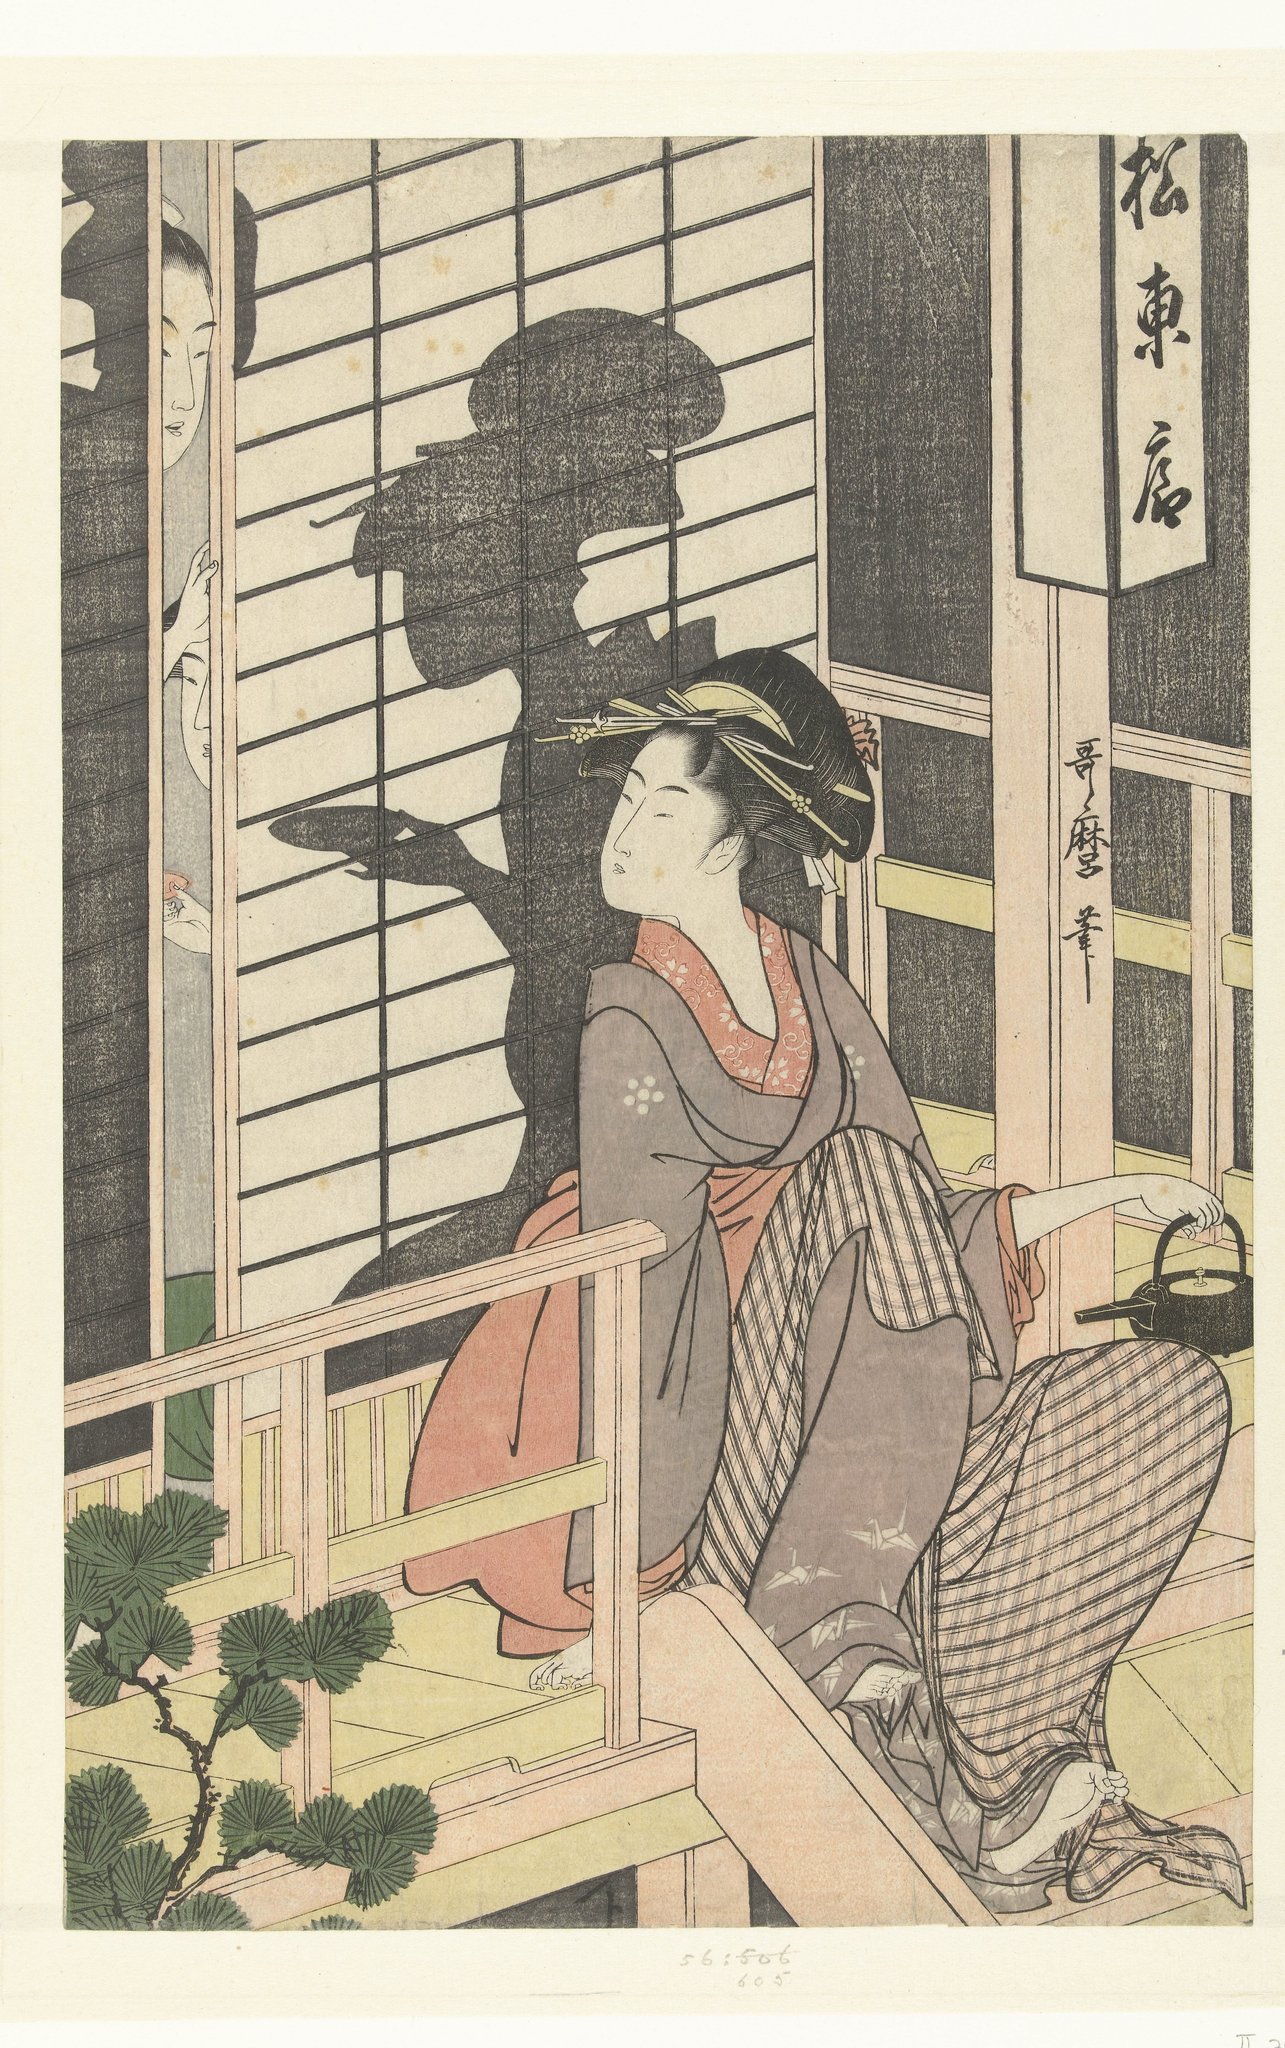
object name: print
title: Waitress at the Matsu Higashi House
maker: kitagawa utamaro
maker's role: print maker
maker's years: 1753-1806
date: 1795-1800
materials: paper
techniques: woodcut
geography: japan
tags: other alcoholic drinks, inn, coffee-house, public house, etc., loggia, verandah, porch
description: Multicolour printing heralded a new high point in Japanese printmaking. One of the most important artists of this period is Utamaro. In this print, he portrayed three women, two of whom can be seen in silhouette, illuminated by an unseen light source behind a sliding paper screen. Utamaro skilfully utilized the natural colour of the unprinted paper to convey the illusion of light.